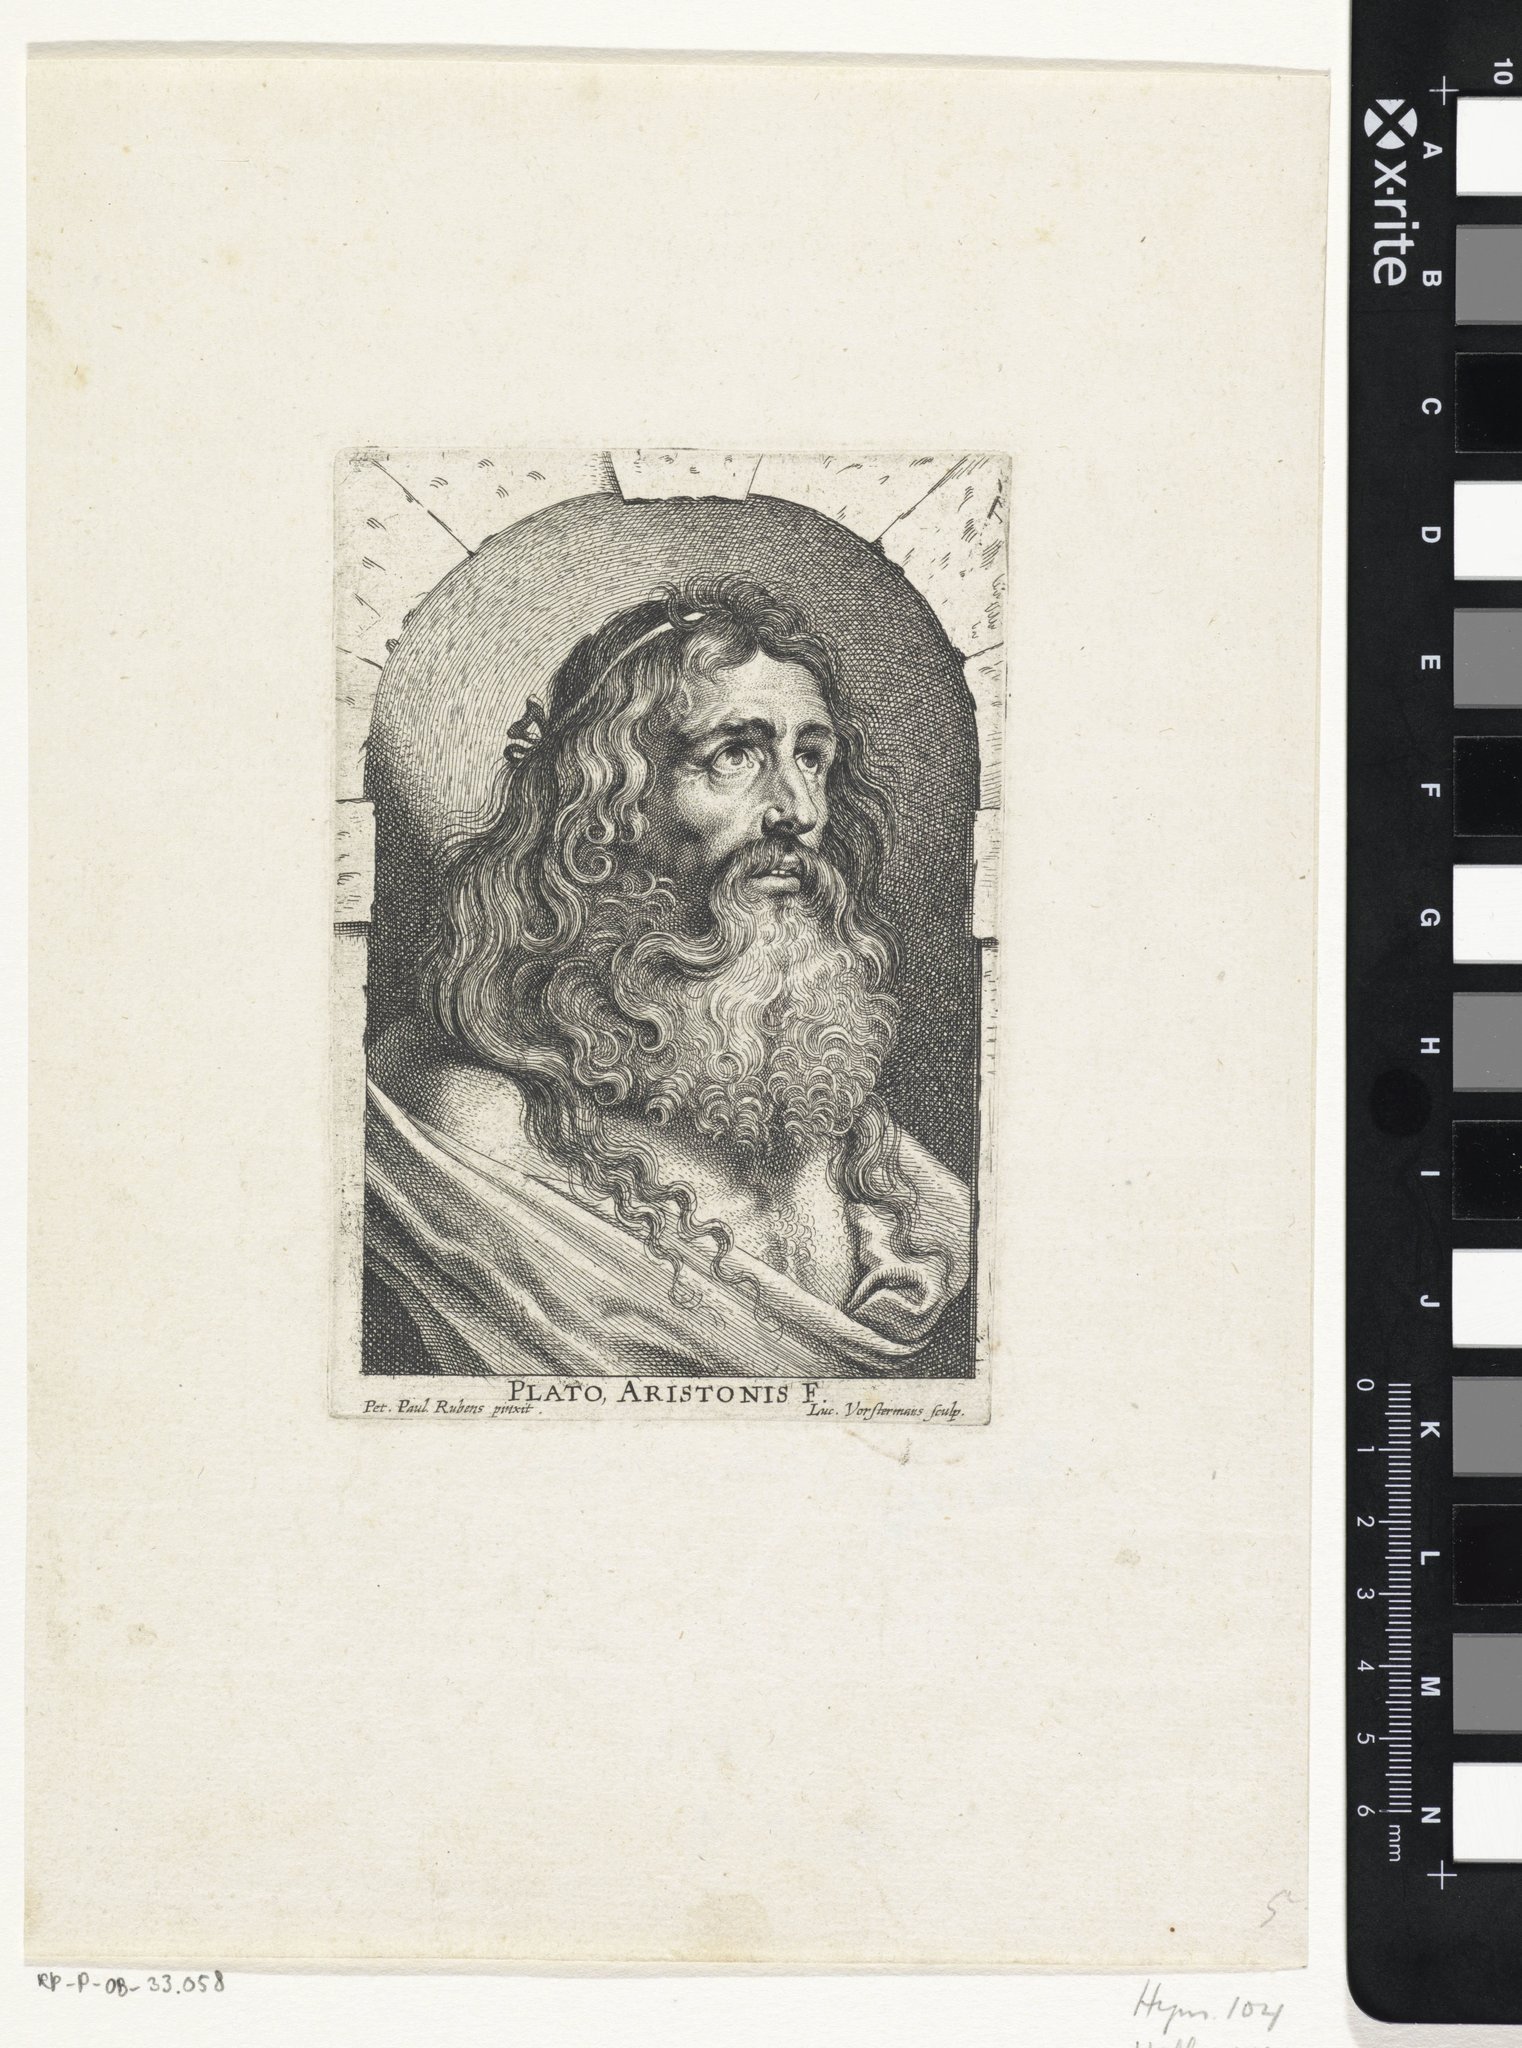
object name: print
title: Buste van Plato in een nis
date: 1619-1675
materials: paper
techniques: engraving, etching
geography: antwerp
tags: male persons from classical history (plato)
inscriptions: collector's mark: Lugt 240